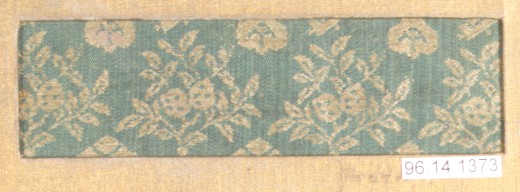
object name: piece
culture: japanese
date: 1701-1900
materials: silk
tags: flowers